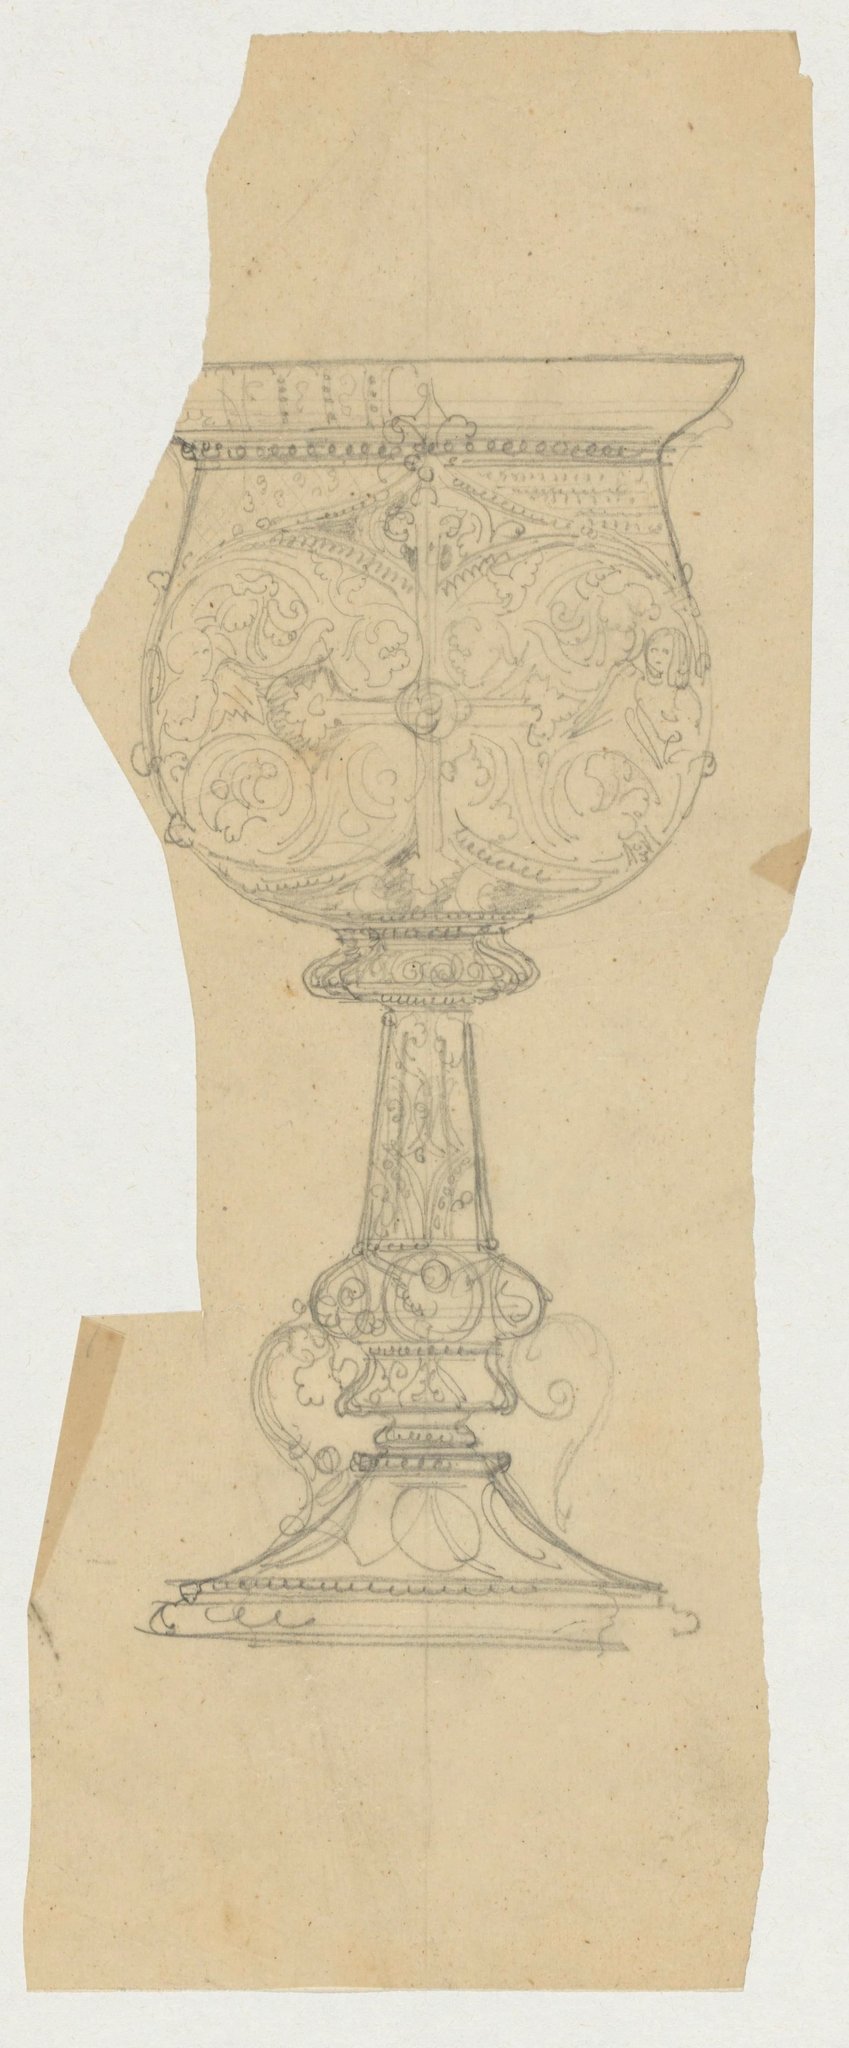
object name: design drawing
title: Kelk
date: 1830-1850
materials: graphite, paper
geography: paris